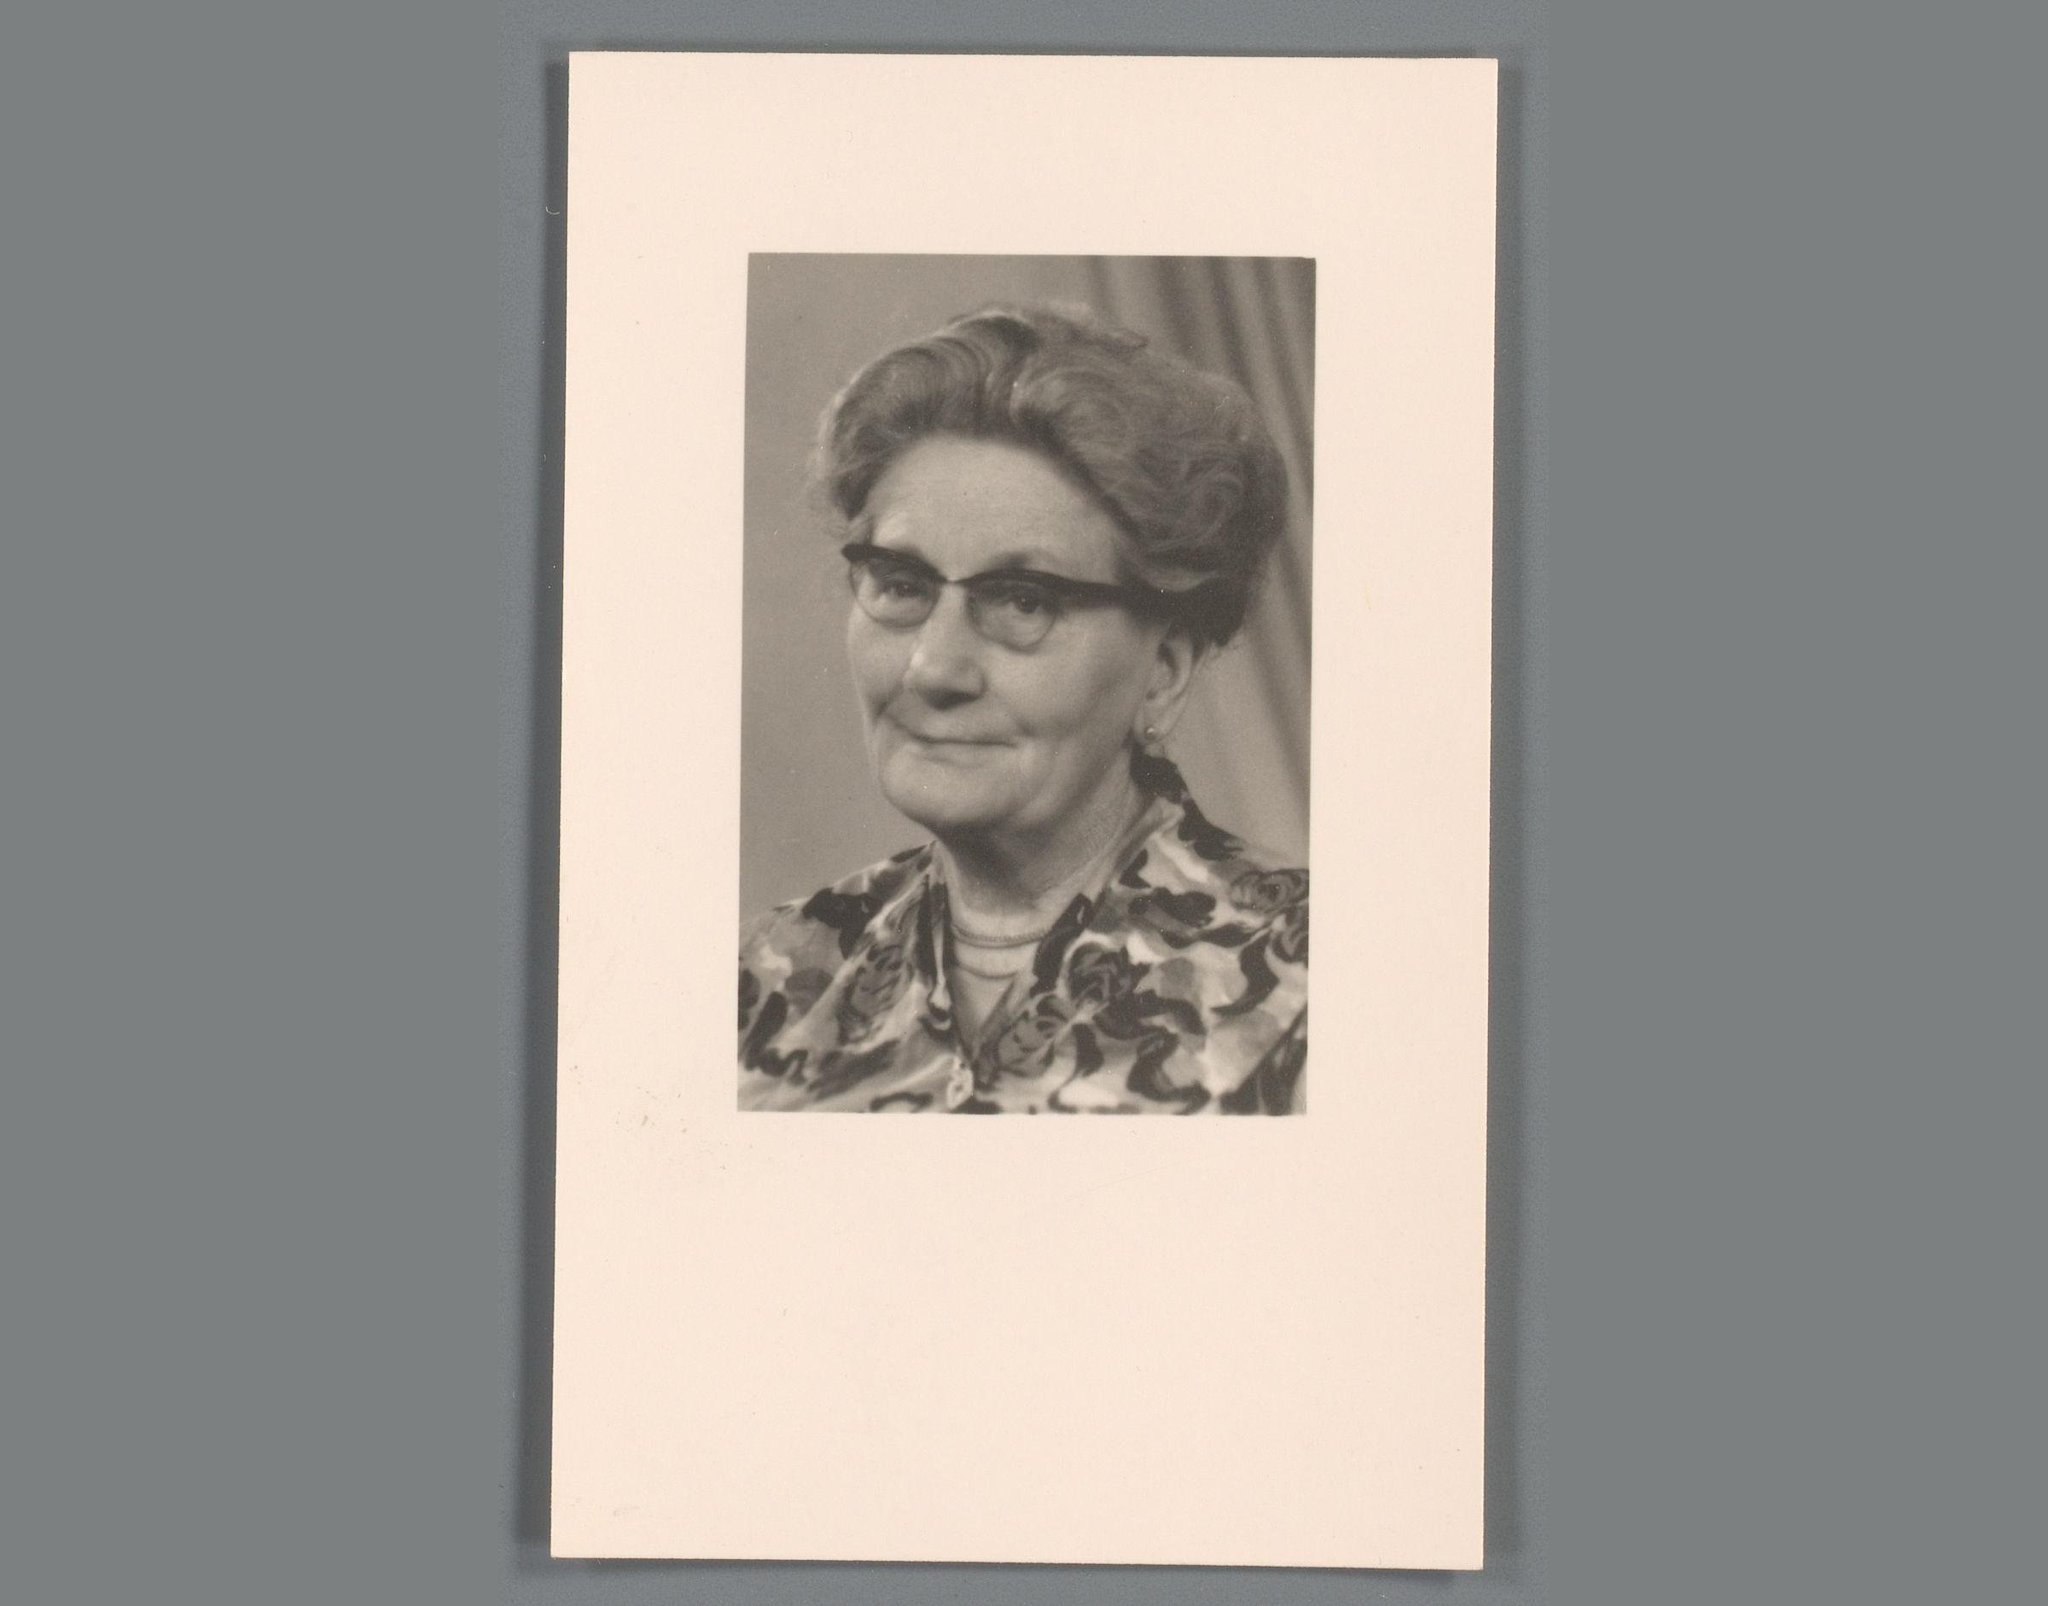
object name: prayer card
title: Portret van Maria Westerweel op bidprent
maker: Anonymous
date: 1968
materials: paper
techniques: gelatin silver print, letterpress printing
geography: hilversum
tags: historical persons, old woman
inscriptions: inscription: ‘Ter dankbare herinnering aan (...) Moge zij rusten met Gods uitverkorenen./ H. Maria, bid voor haar.’